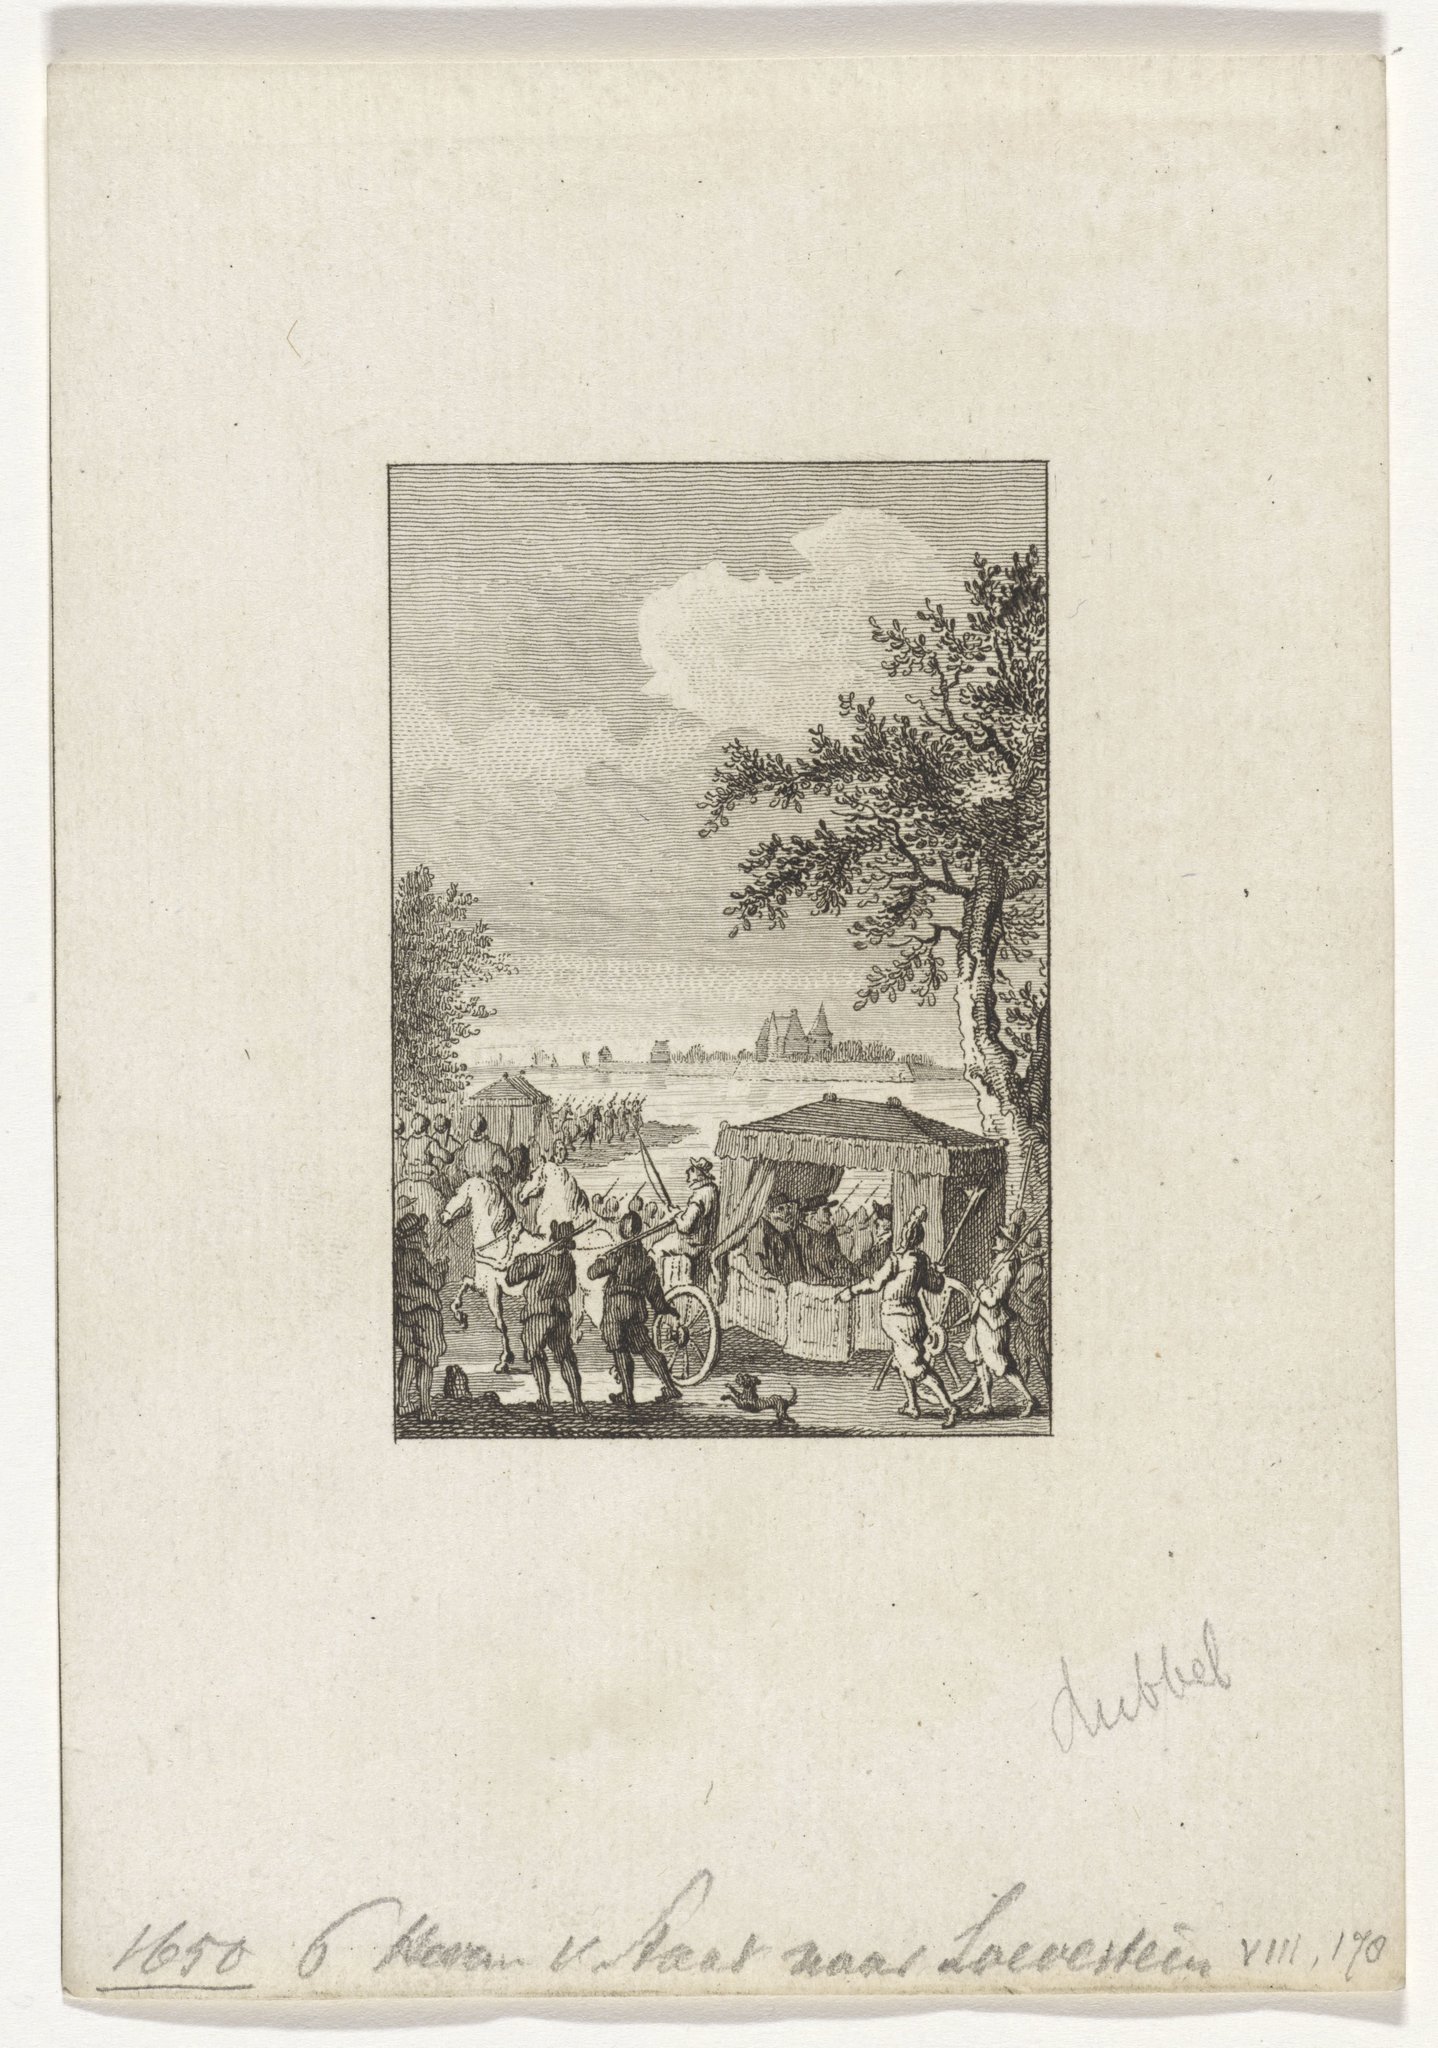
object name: print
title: Gearresteerde statenleden afgevoerd naar Loevestein, 1650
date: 1780-1795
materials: paper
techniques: etching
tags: william ii (prince of orange), dordrecht, mayor, arrest (of criminal), loevestein castle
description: Gebruikt als illustratie in: J. Fokke, Geschiedenissen der Vereenigde Nederlanden voor de vaderlandsche jeugd, Johannes Allart, Amsterdam 1783-1795, 25 delen, dl. VIII, pl. IV.